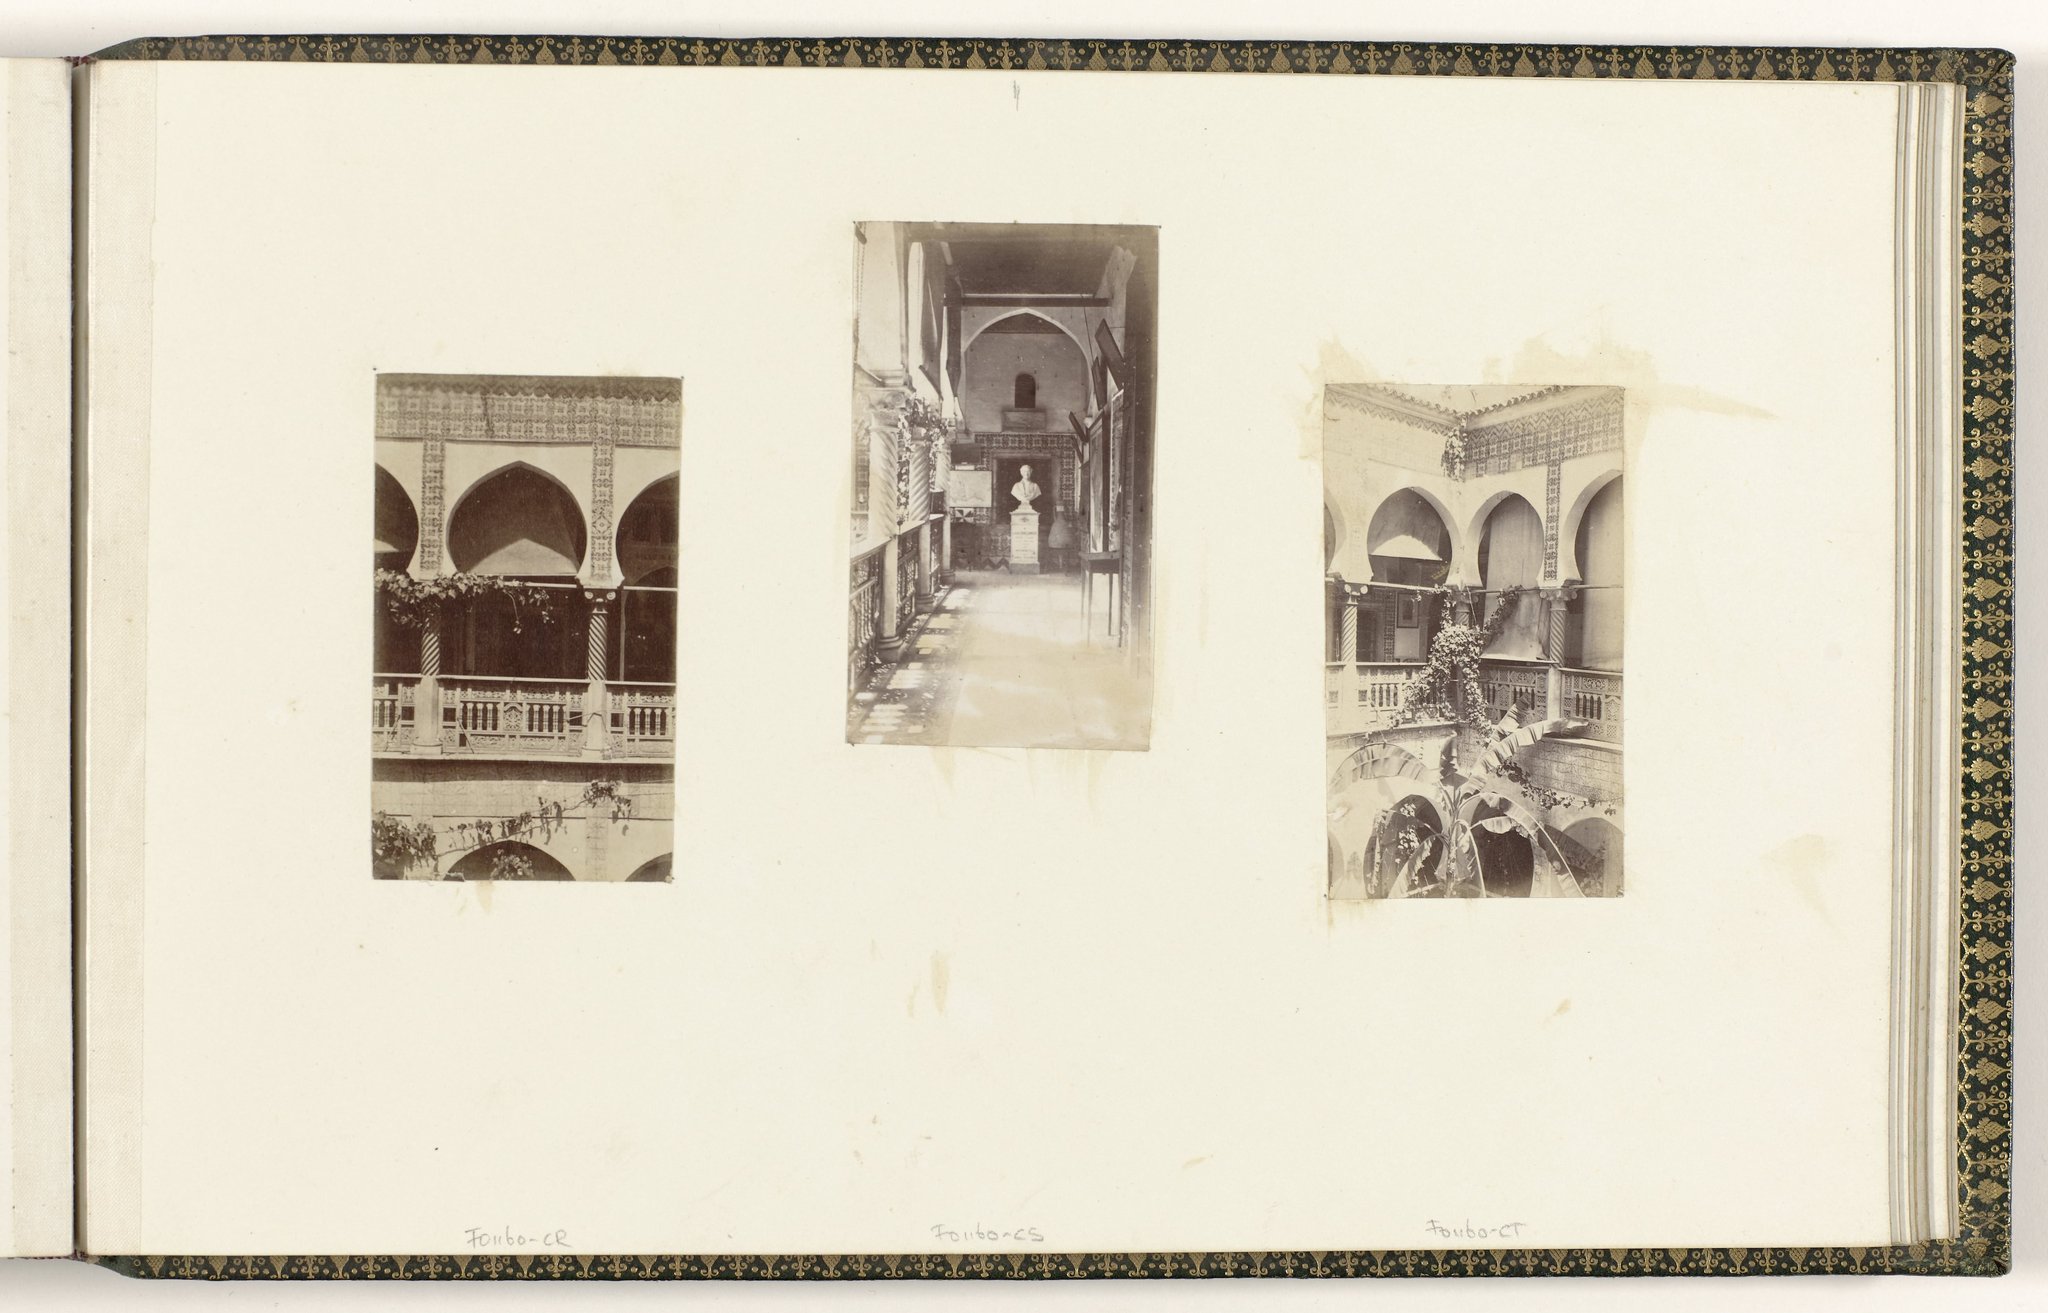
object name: album leaf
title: Zicht in een galerij met een buste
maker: Anonymous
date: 1870-1880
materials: paper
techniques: albumen print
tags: gallery (spacious corridor)